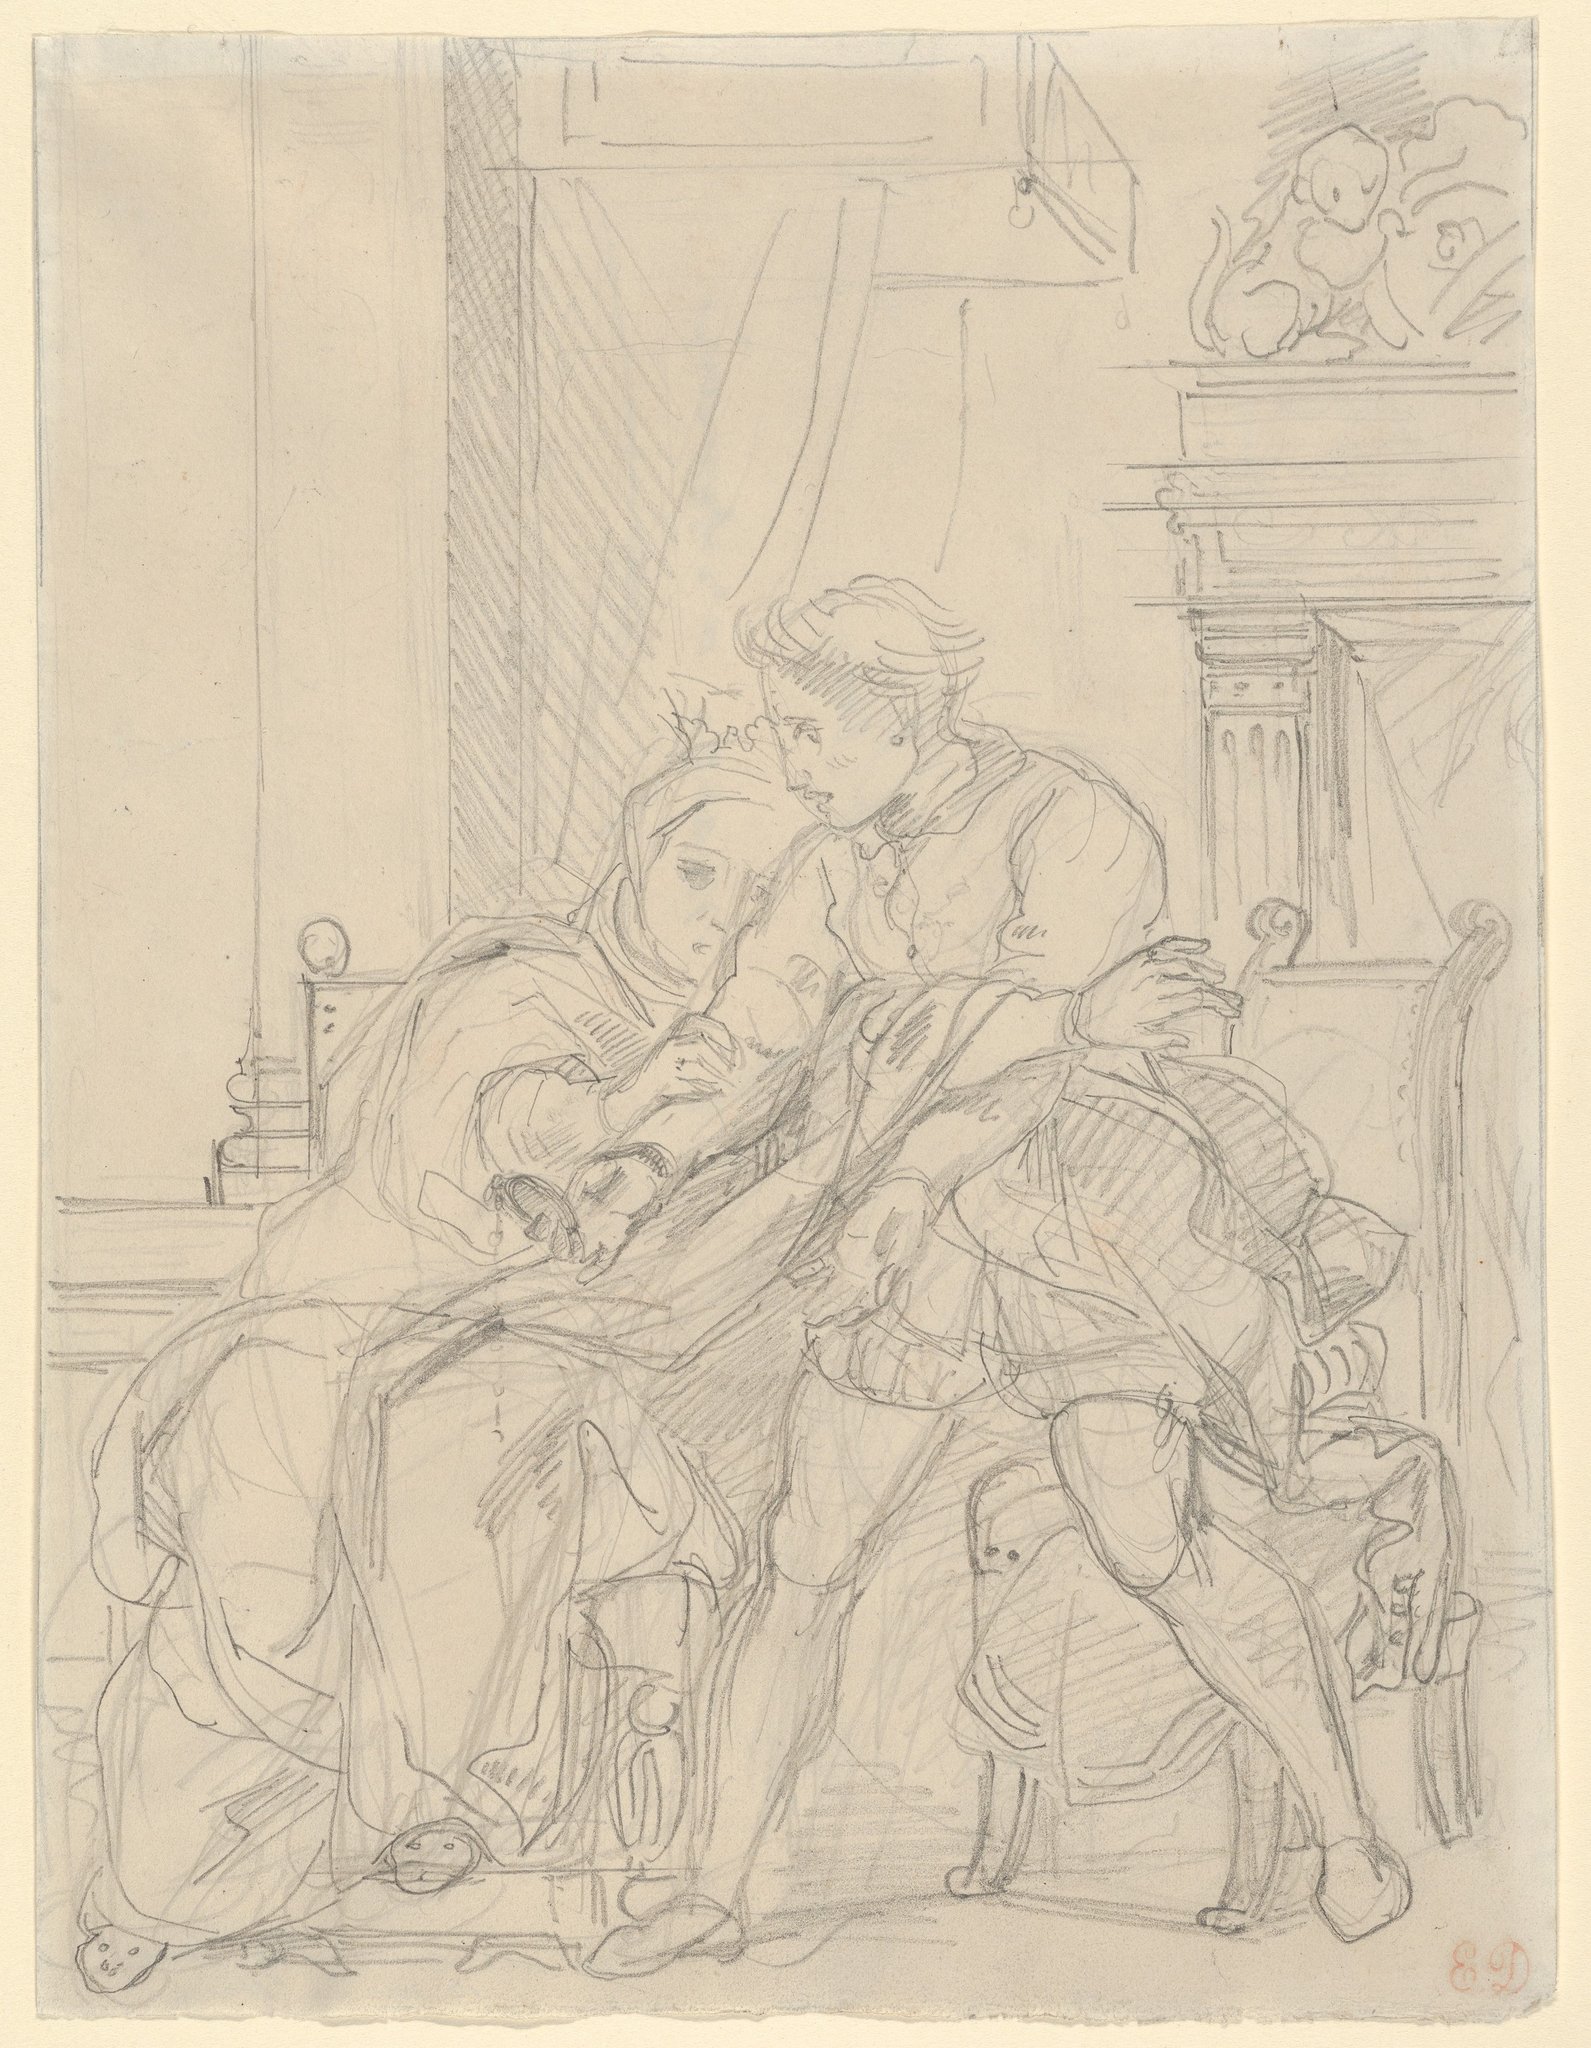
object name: drawing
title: Hamlet Reproaches His Mother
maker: eugène delacroix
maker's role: artist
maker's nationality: french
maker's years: 1798-1863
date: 1834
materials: graphite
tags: shakespeare,men,women,hamlet